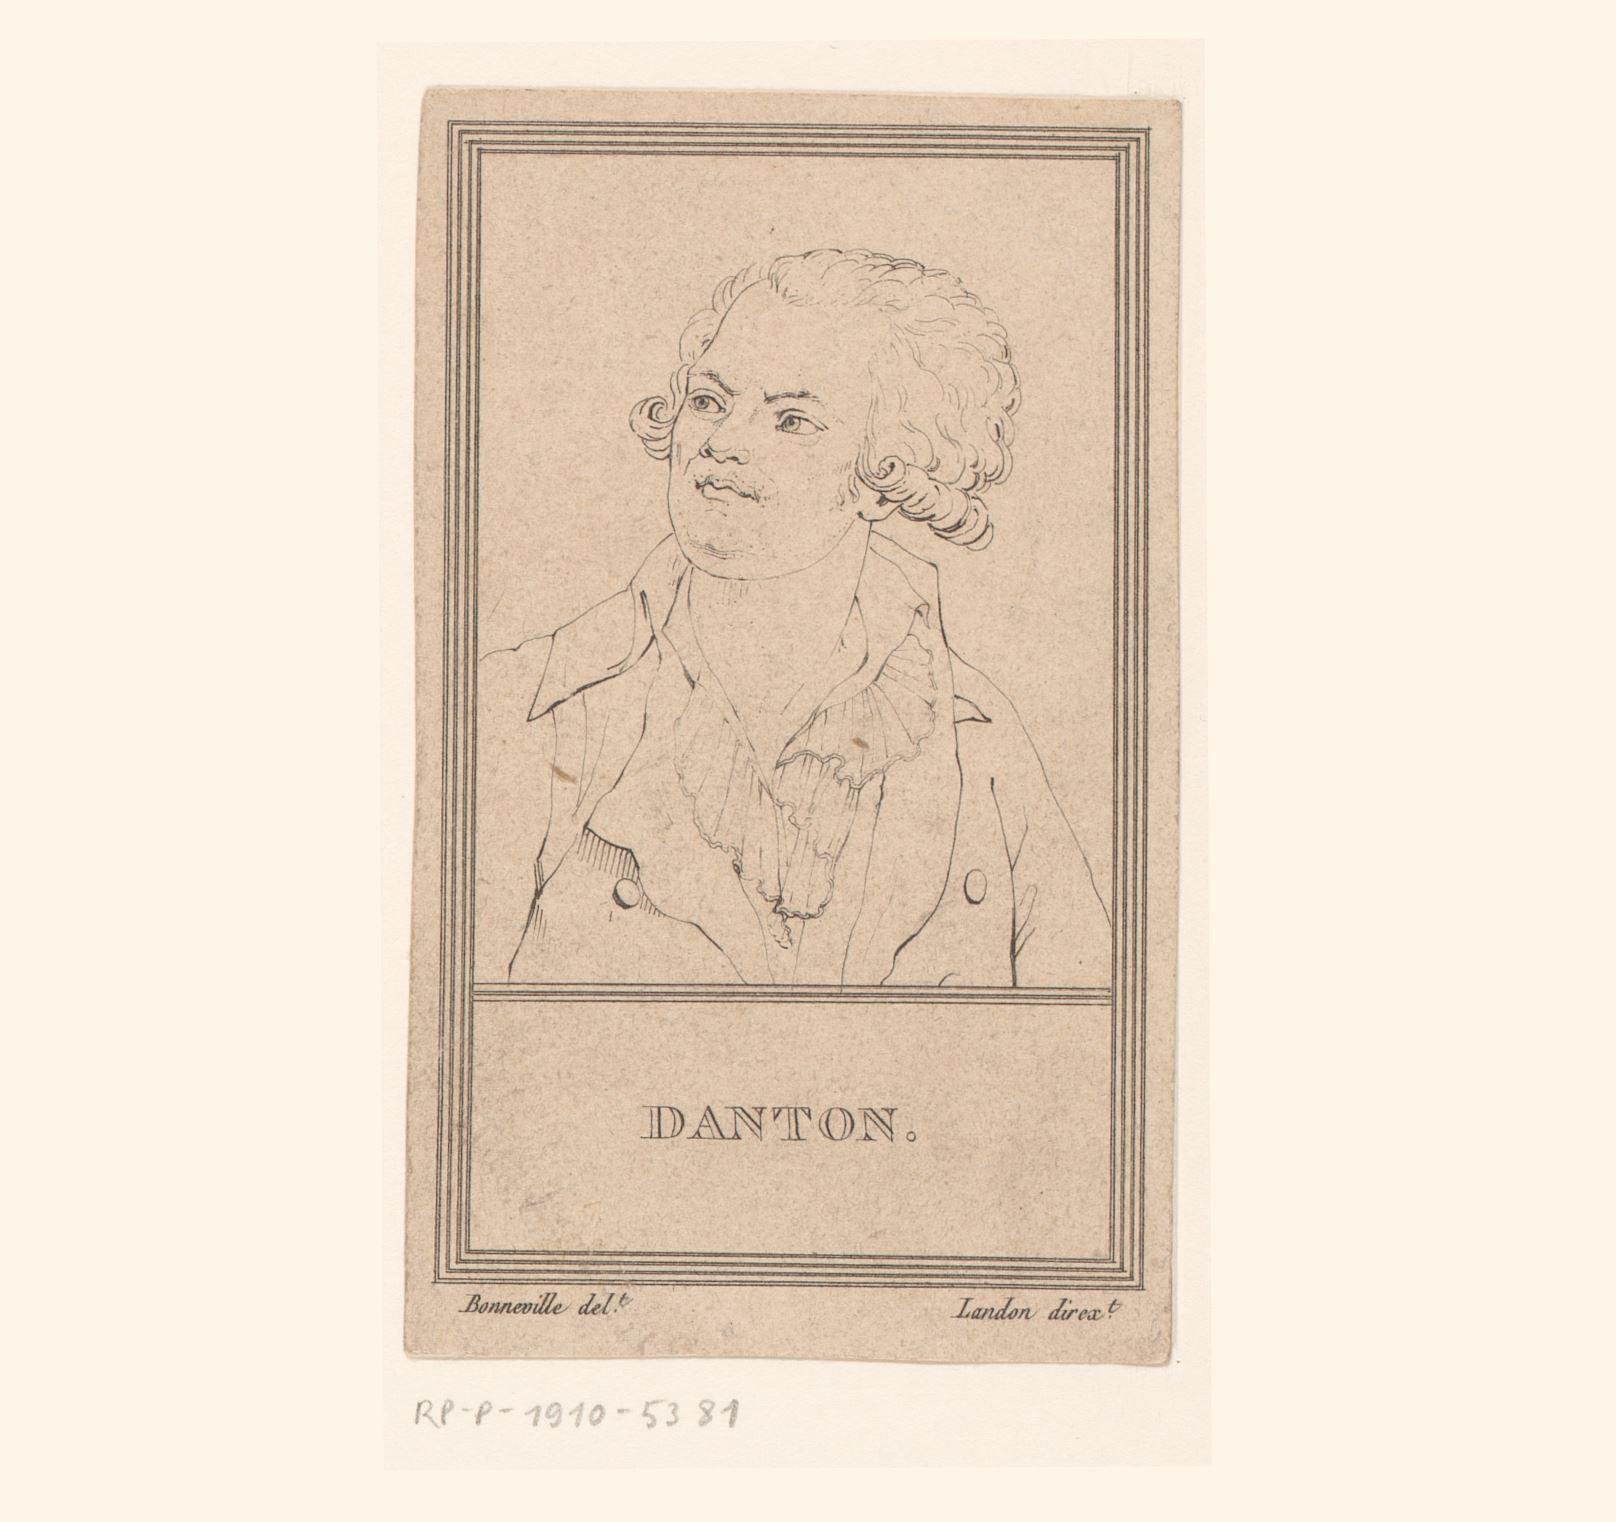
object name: print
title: Danton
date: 1805-1811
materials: paper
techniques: etching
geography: france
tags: paris, politician, historical persons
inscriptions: collector's mark: Lugt 2228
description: Prent uit: Landon, Charles Paul. Galerie historique des hommes les plus celebres de tous les nations. (...). Parijs: Musée et l'école des beaux-arts, 1805-1811.